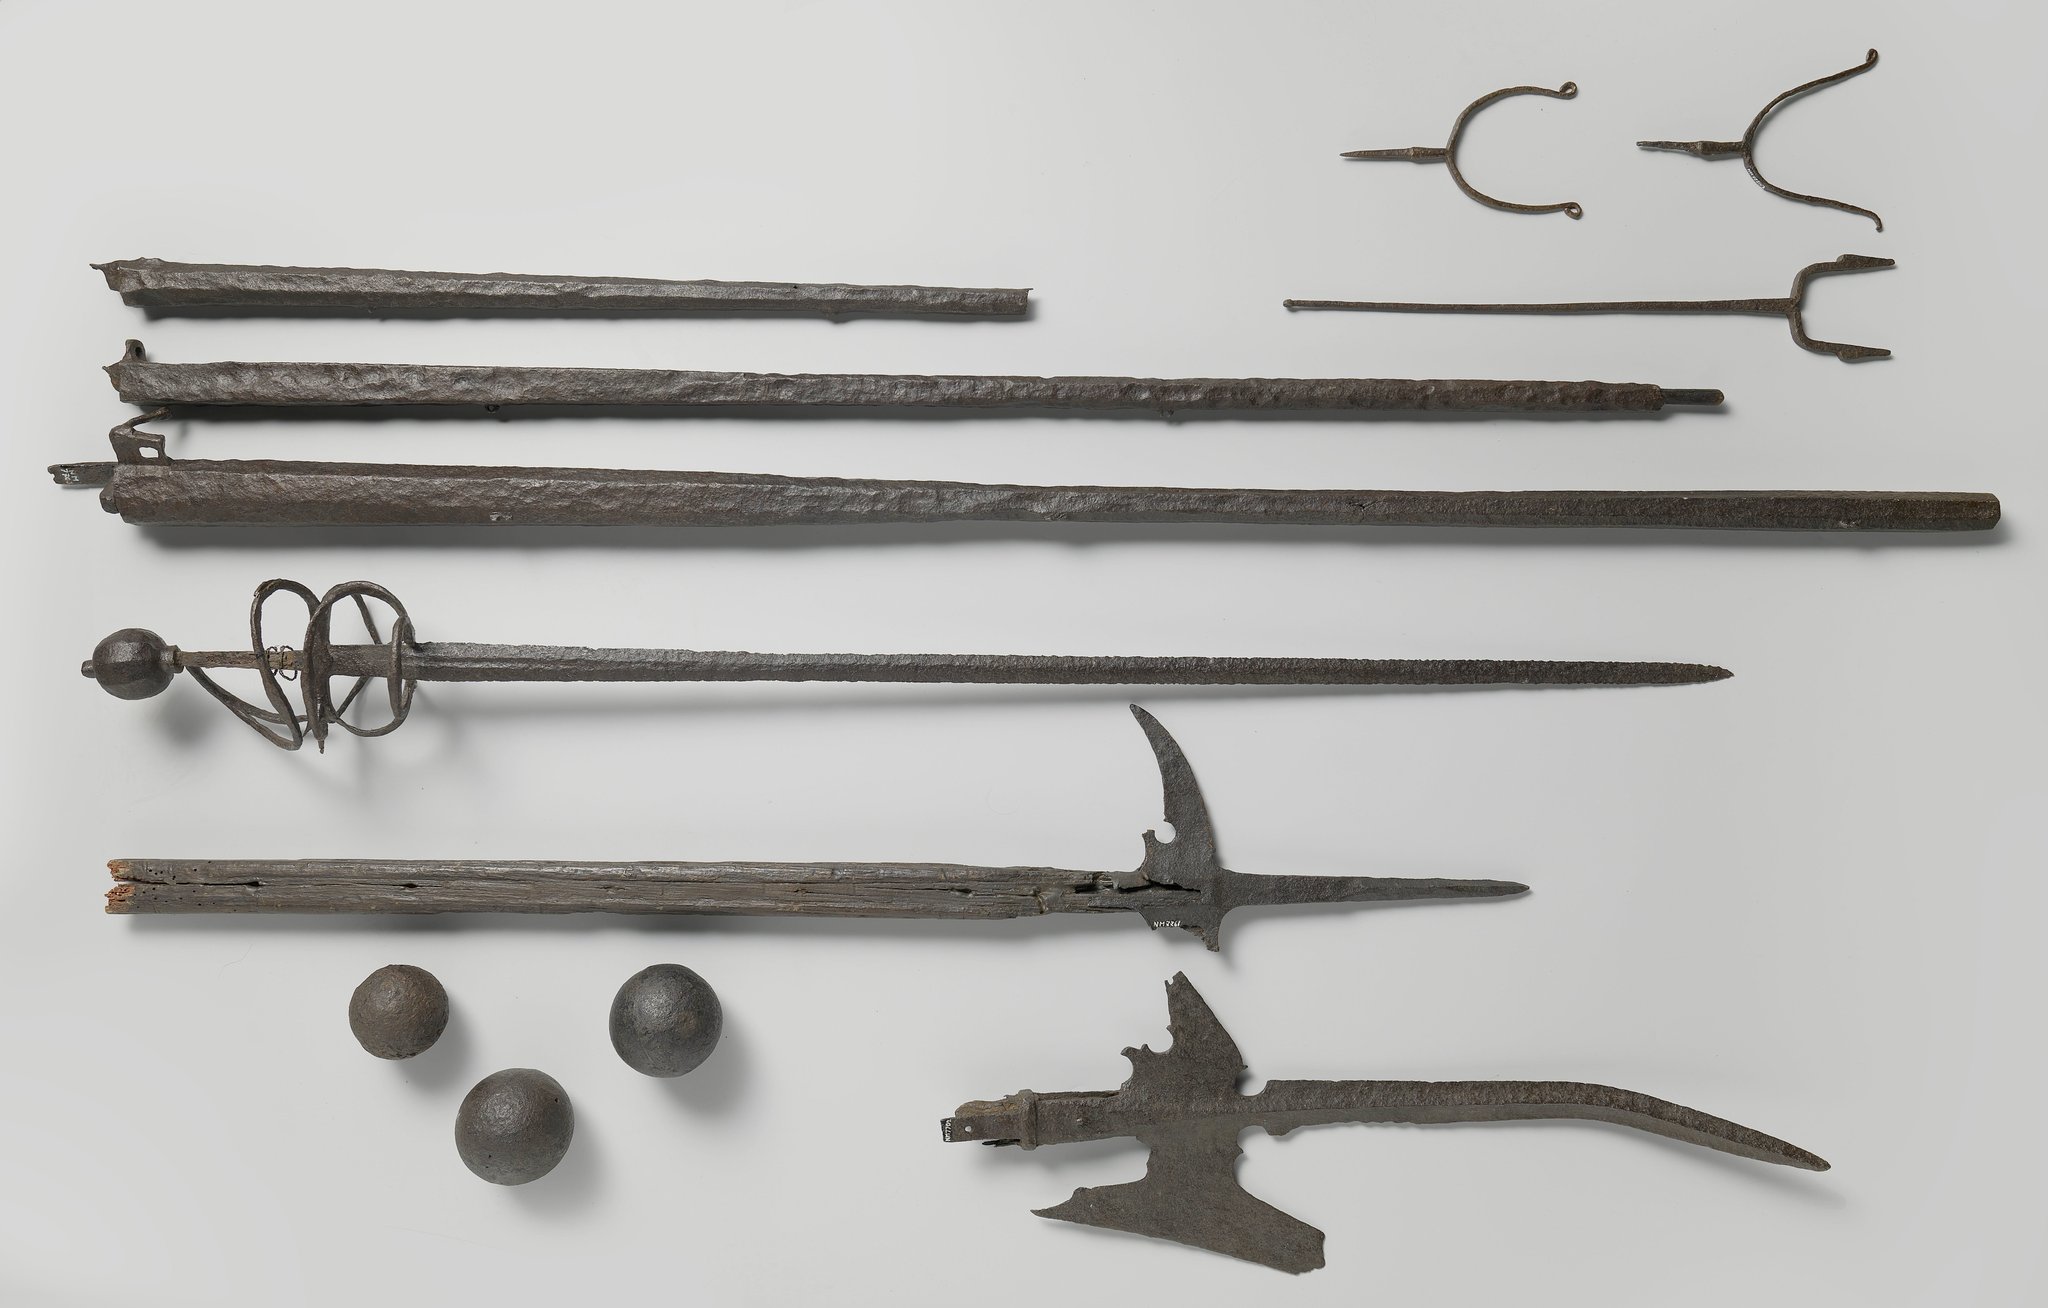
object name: roer wapen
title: Loop van een roer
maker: Anonymous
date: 1590-1596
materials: iron, wood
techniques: forging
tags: willem barendsz., amsterdam, jacob van heemskerck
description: Loop van een roer, vermoedelijk een snaphaanroer, met een ijzeren loop, een vierkante kamer, een monding met een achthoekige doorsnede, een vizier en twee haften aan de onderzijde. De houten pen in de loop, steekt uit. De kistvormige kamer van de loop en het merkwaardige dioptervizier geven aanleiding tot het vermoeden dat deze loop behoort bij het snaphaanslot NG-NM-7762-7763. De houten pen in de loop, steekt uit.